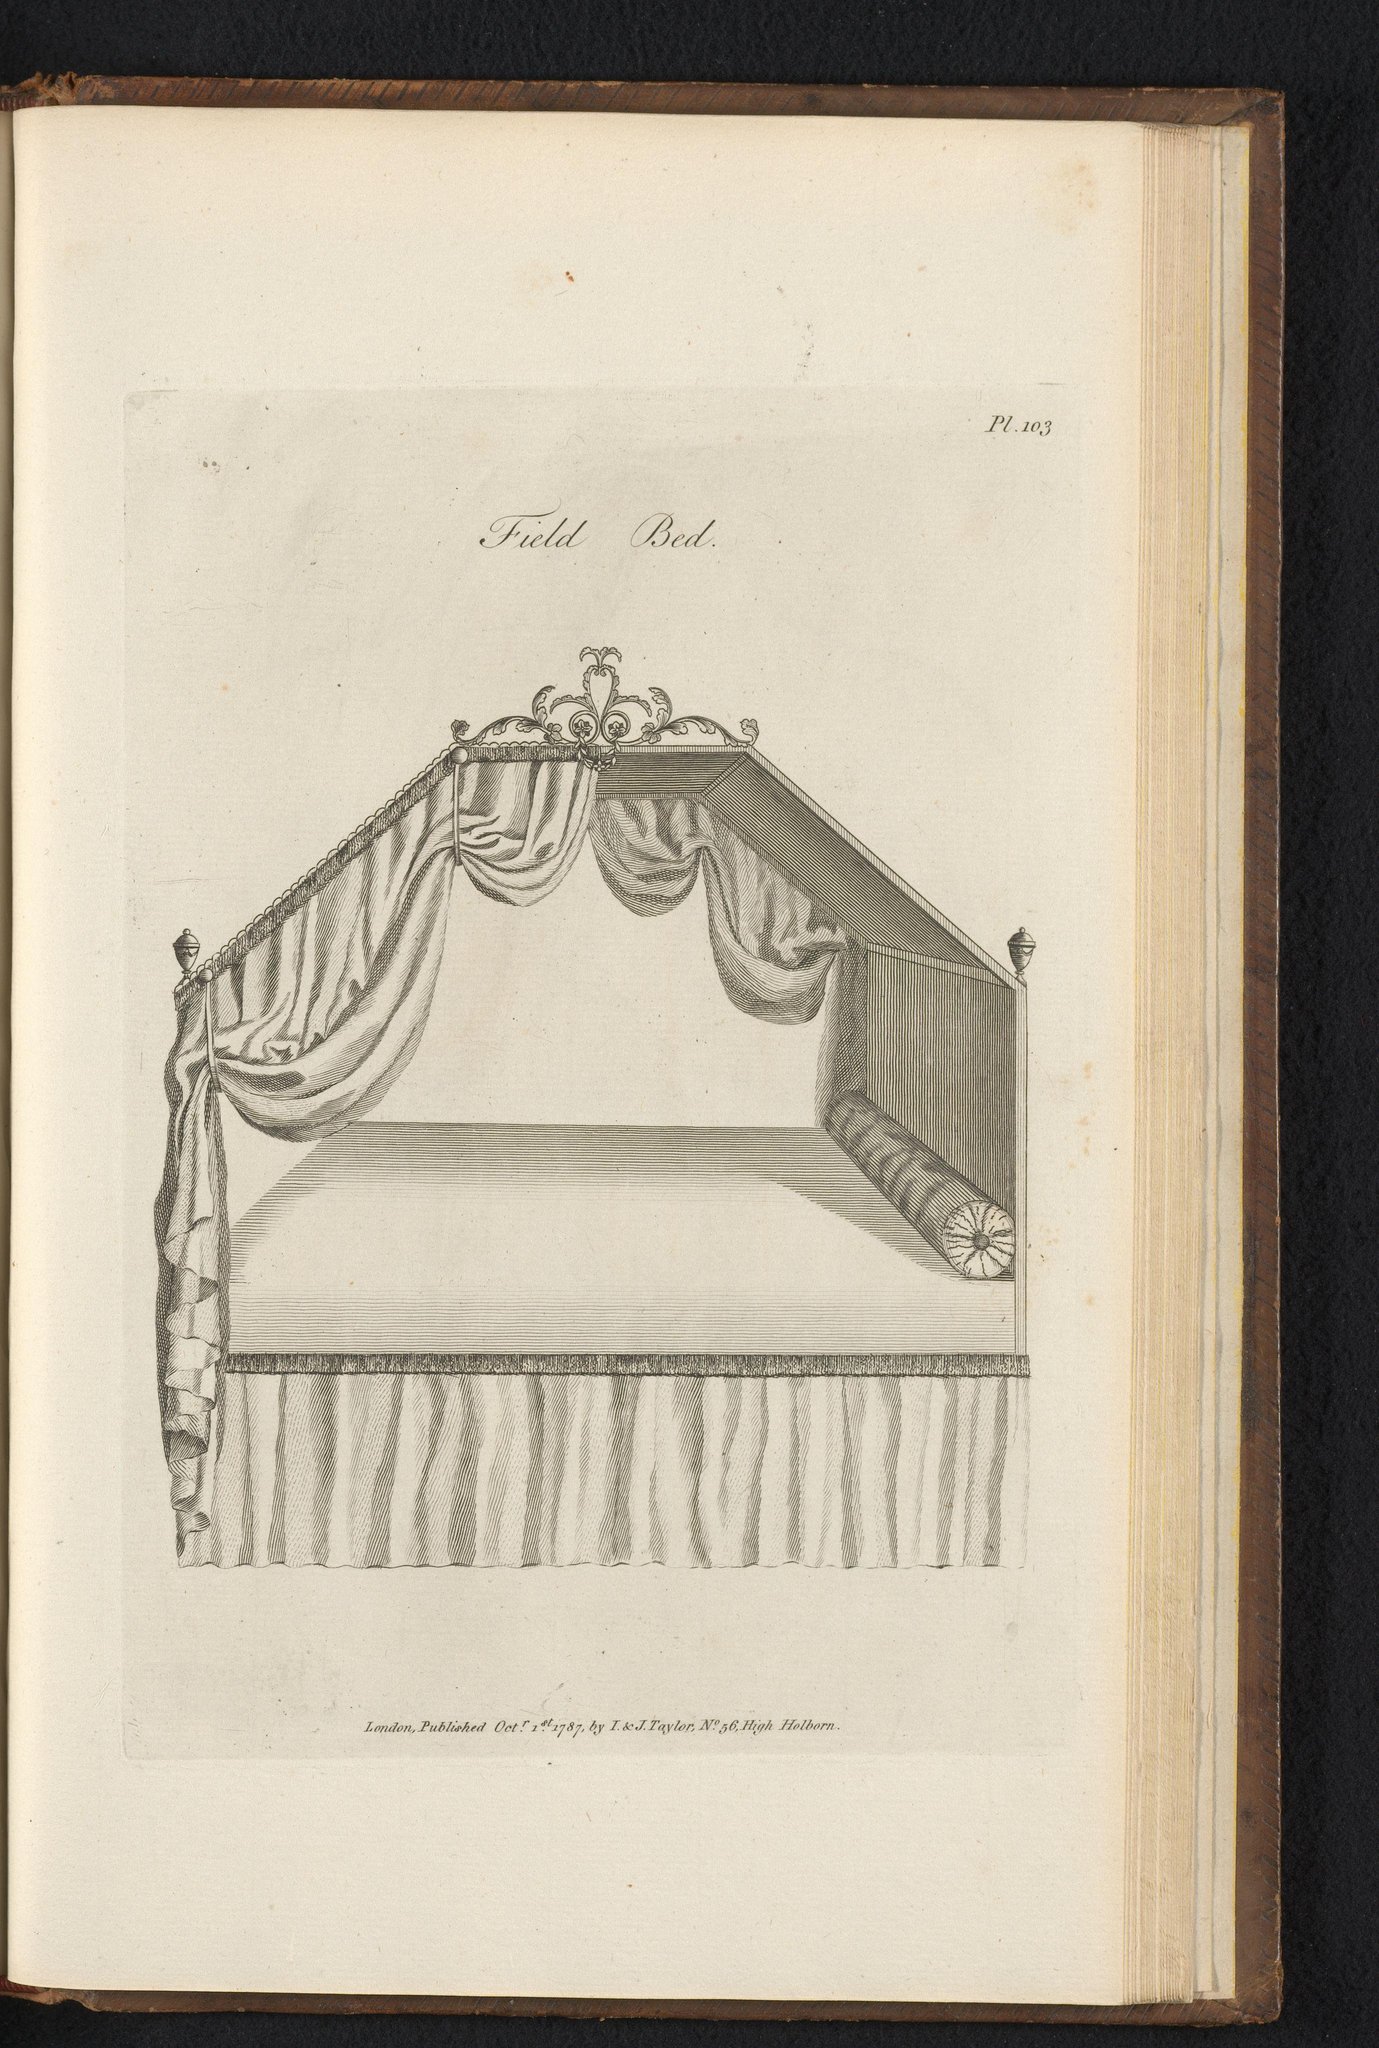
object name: page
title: Meubels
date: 1787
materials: paper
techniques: engraving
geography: holborn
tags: bed, tent-camp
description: Genummerd: Pl. 103. Prent maakt deel uit van een boek.